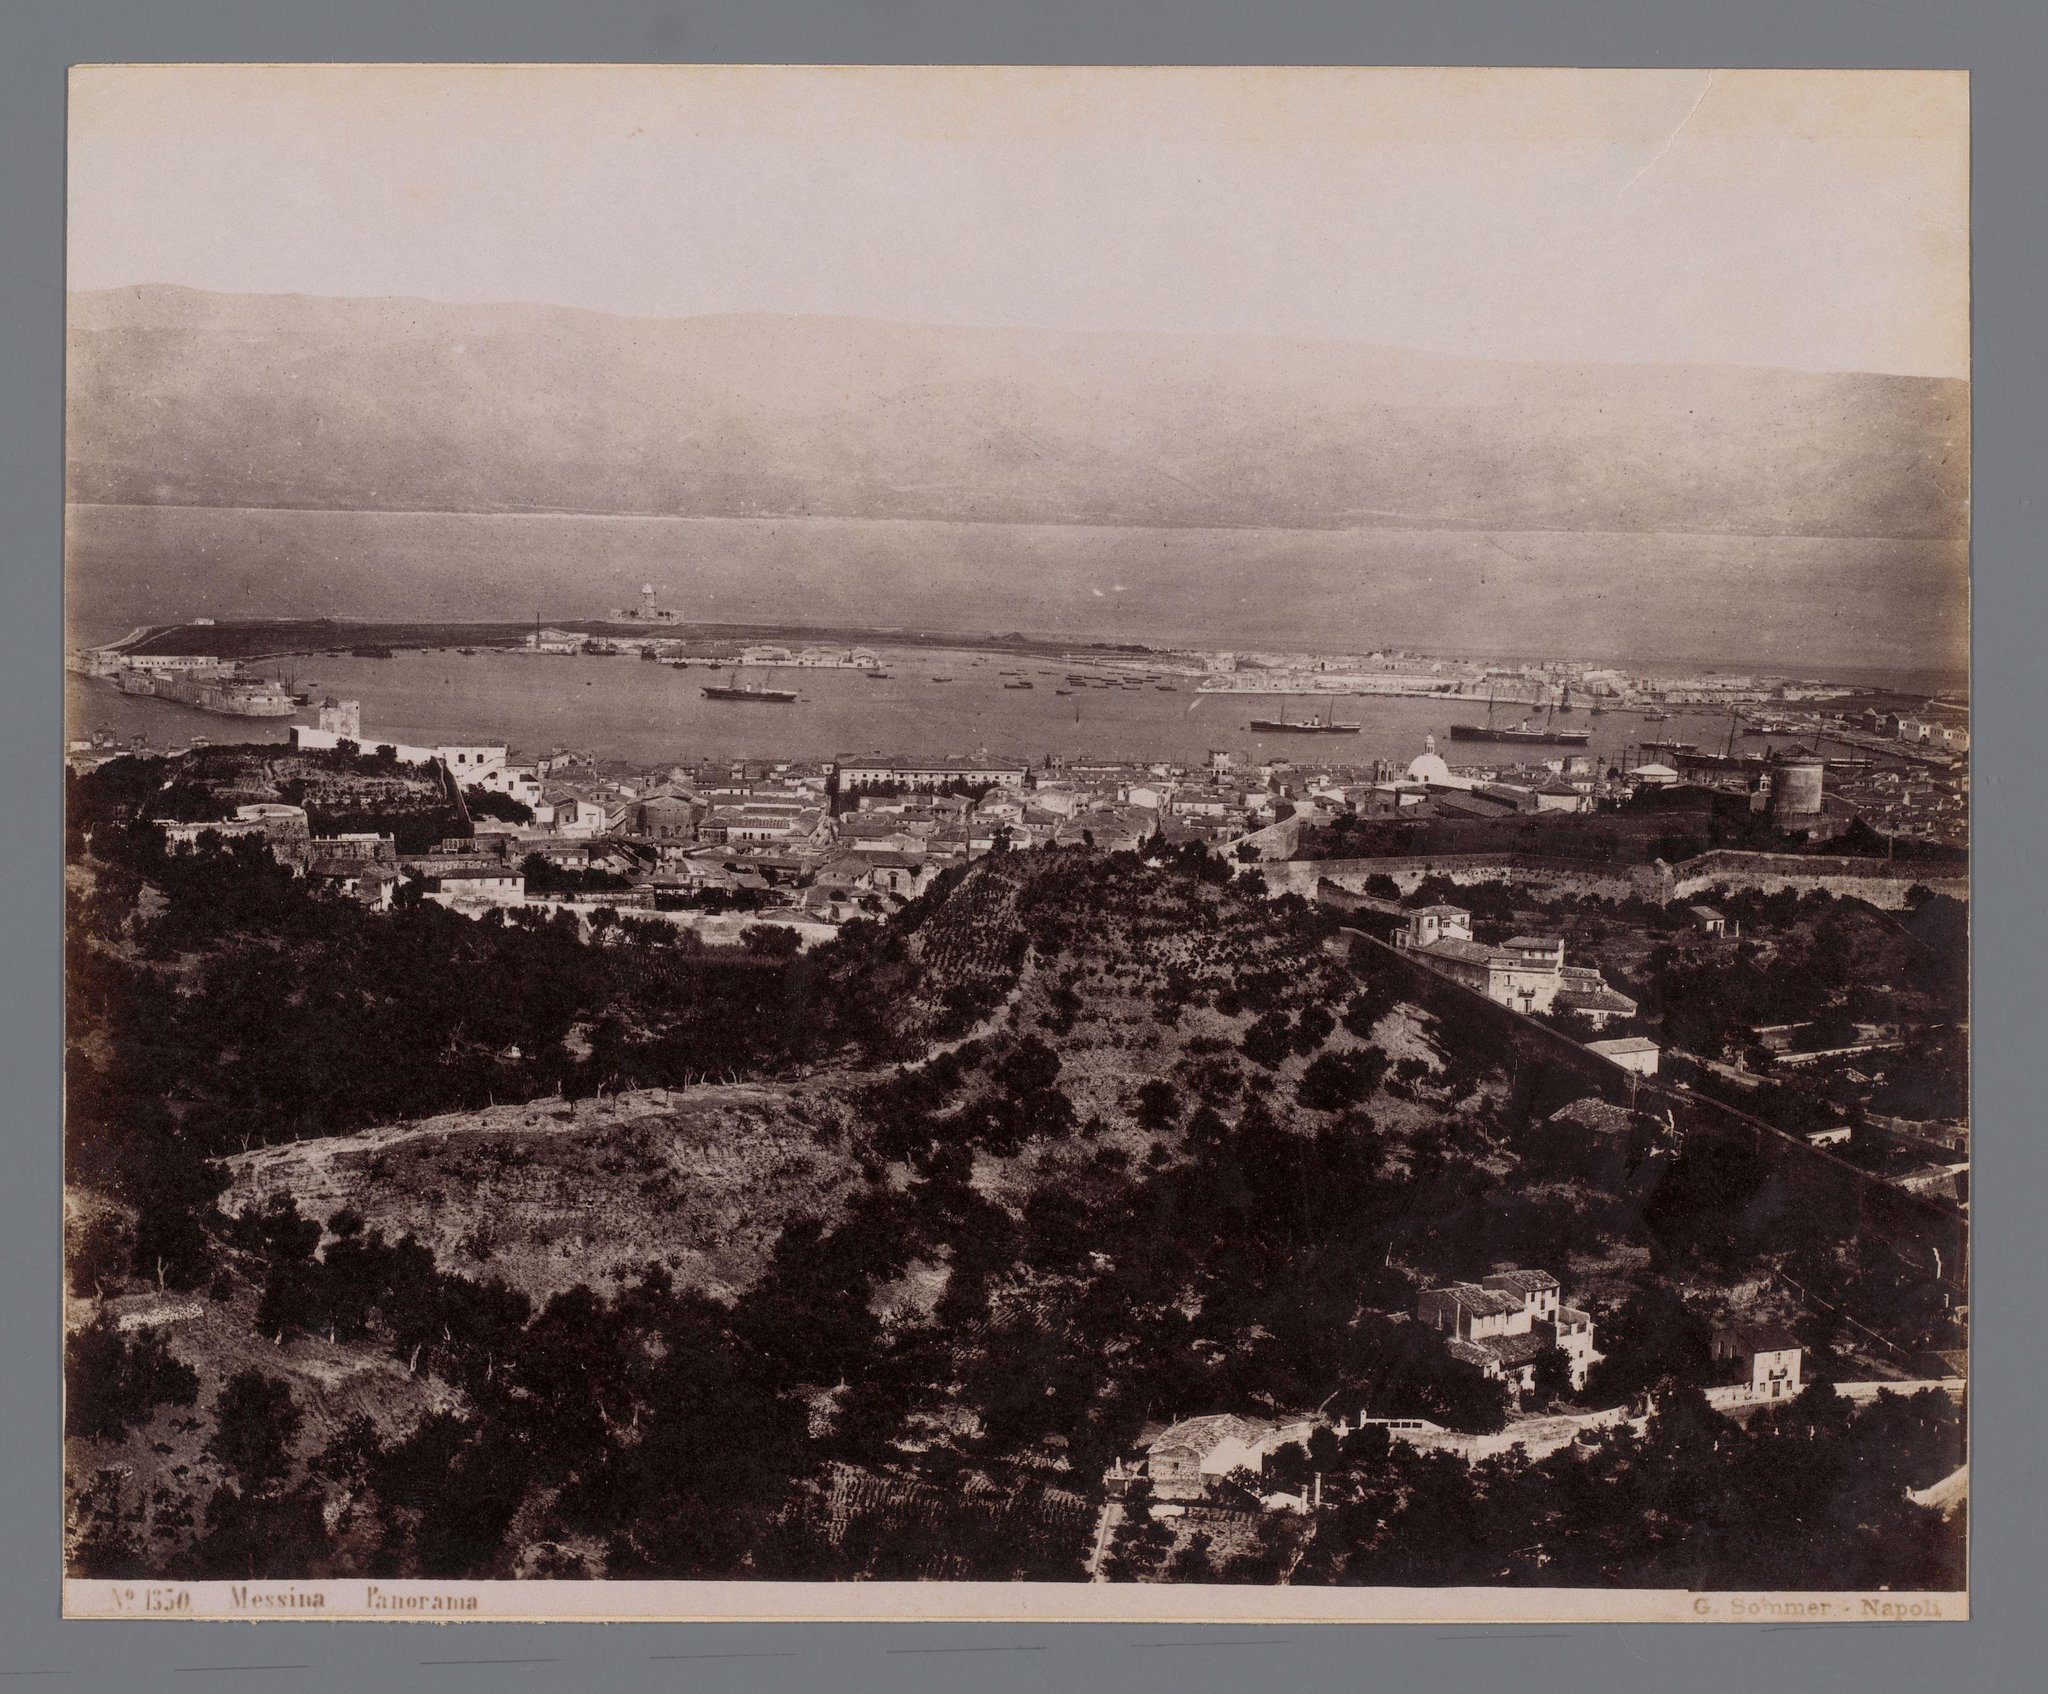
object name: photograph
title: Gezicht op Messina, Italië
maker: giorgio sommer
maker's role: fotograaf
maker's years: 1834-1914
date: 1857-1914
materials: paper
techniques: albumen print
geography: messina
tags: harbour, prospect of city, town panorama, silhouette of city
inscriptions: number: ‘No. 1330’